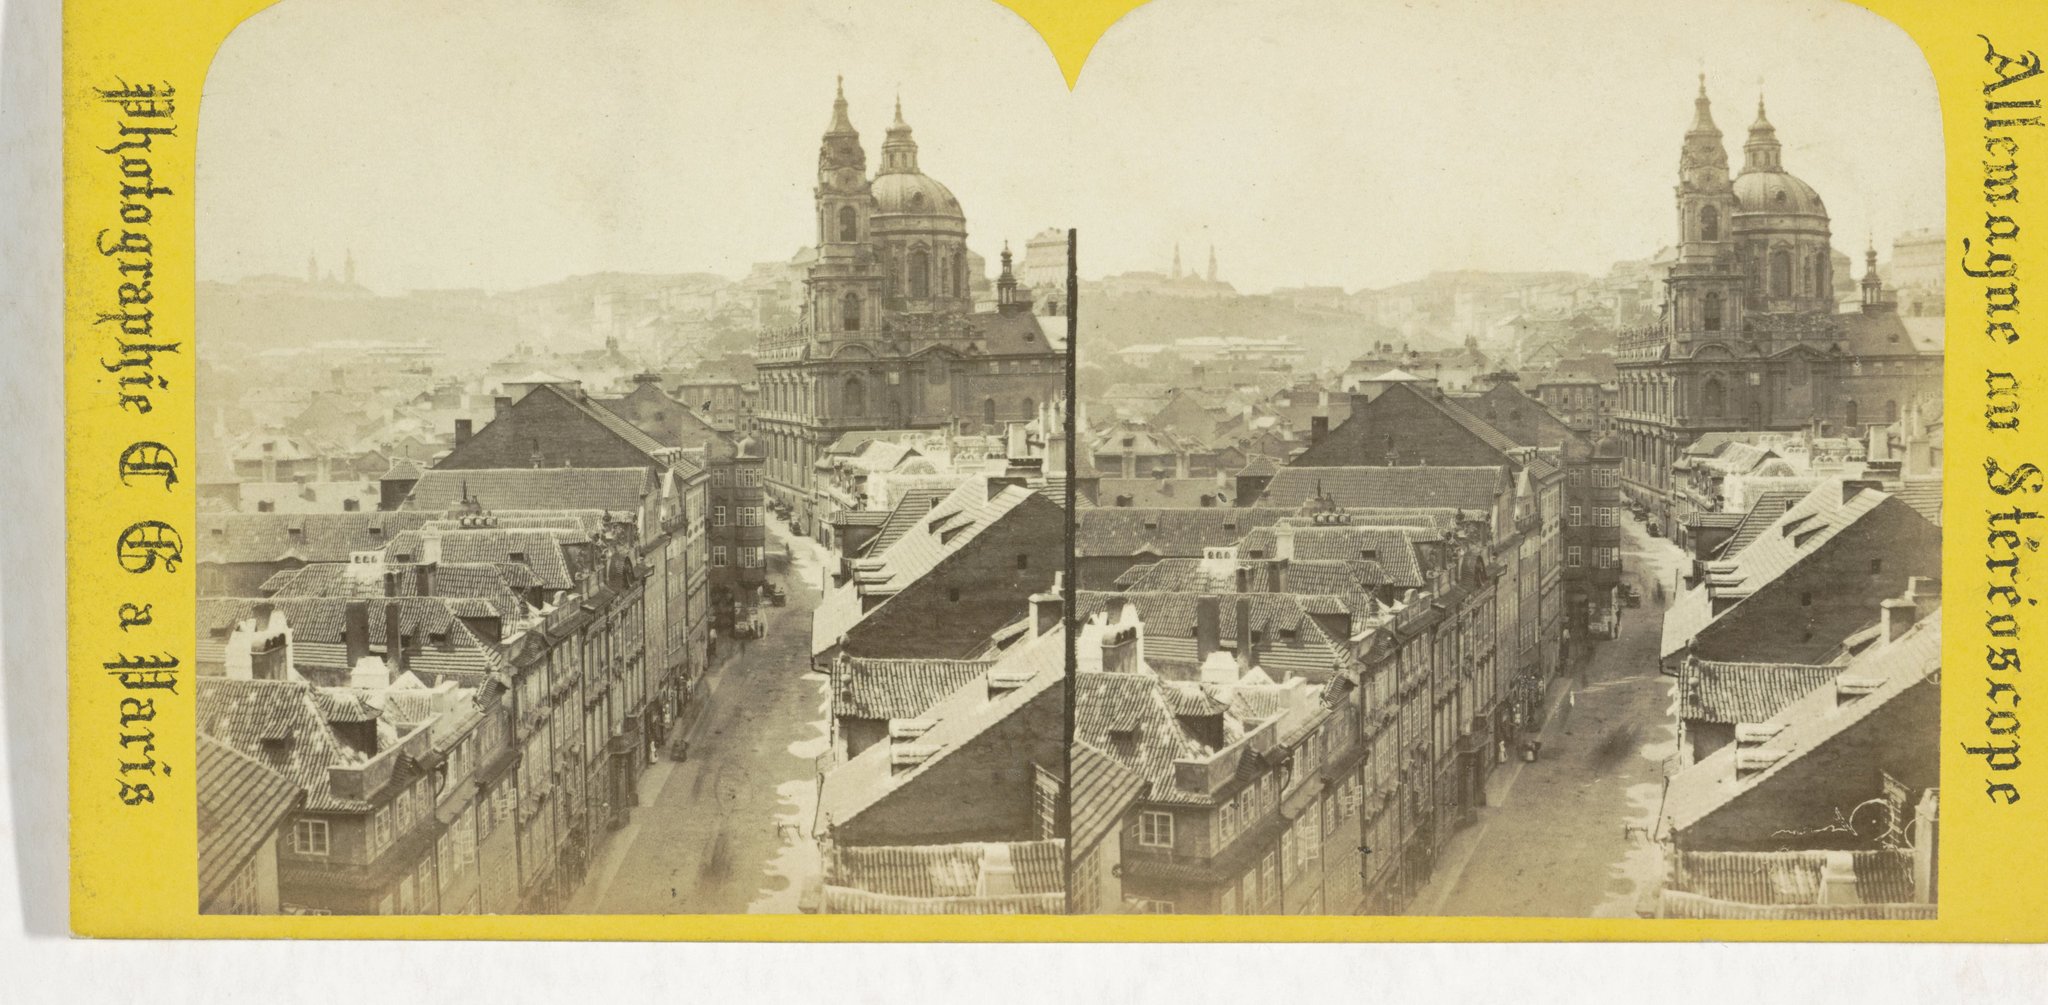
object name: stereograph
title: Gezicht op de Kostel svatého Mikuláše of Sint-Nicolaaskerk, Malá Strana, Praag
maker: charles gaudin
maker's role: publisher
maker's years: 1825-1905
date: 1868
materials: cardboard, paper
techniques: albumen print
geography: prague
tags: city-view in general; 'veduta', church (exterior), prague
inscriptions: number: ‘197’, inscription: ‘187 Jc.t. [?]’